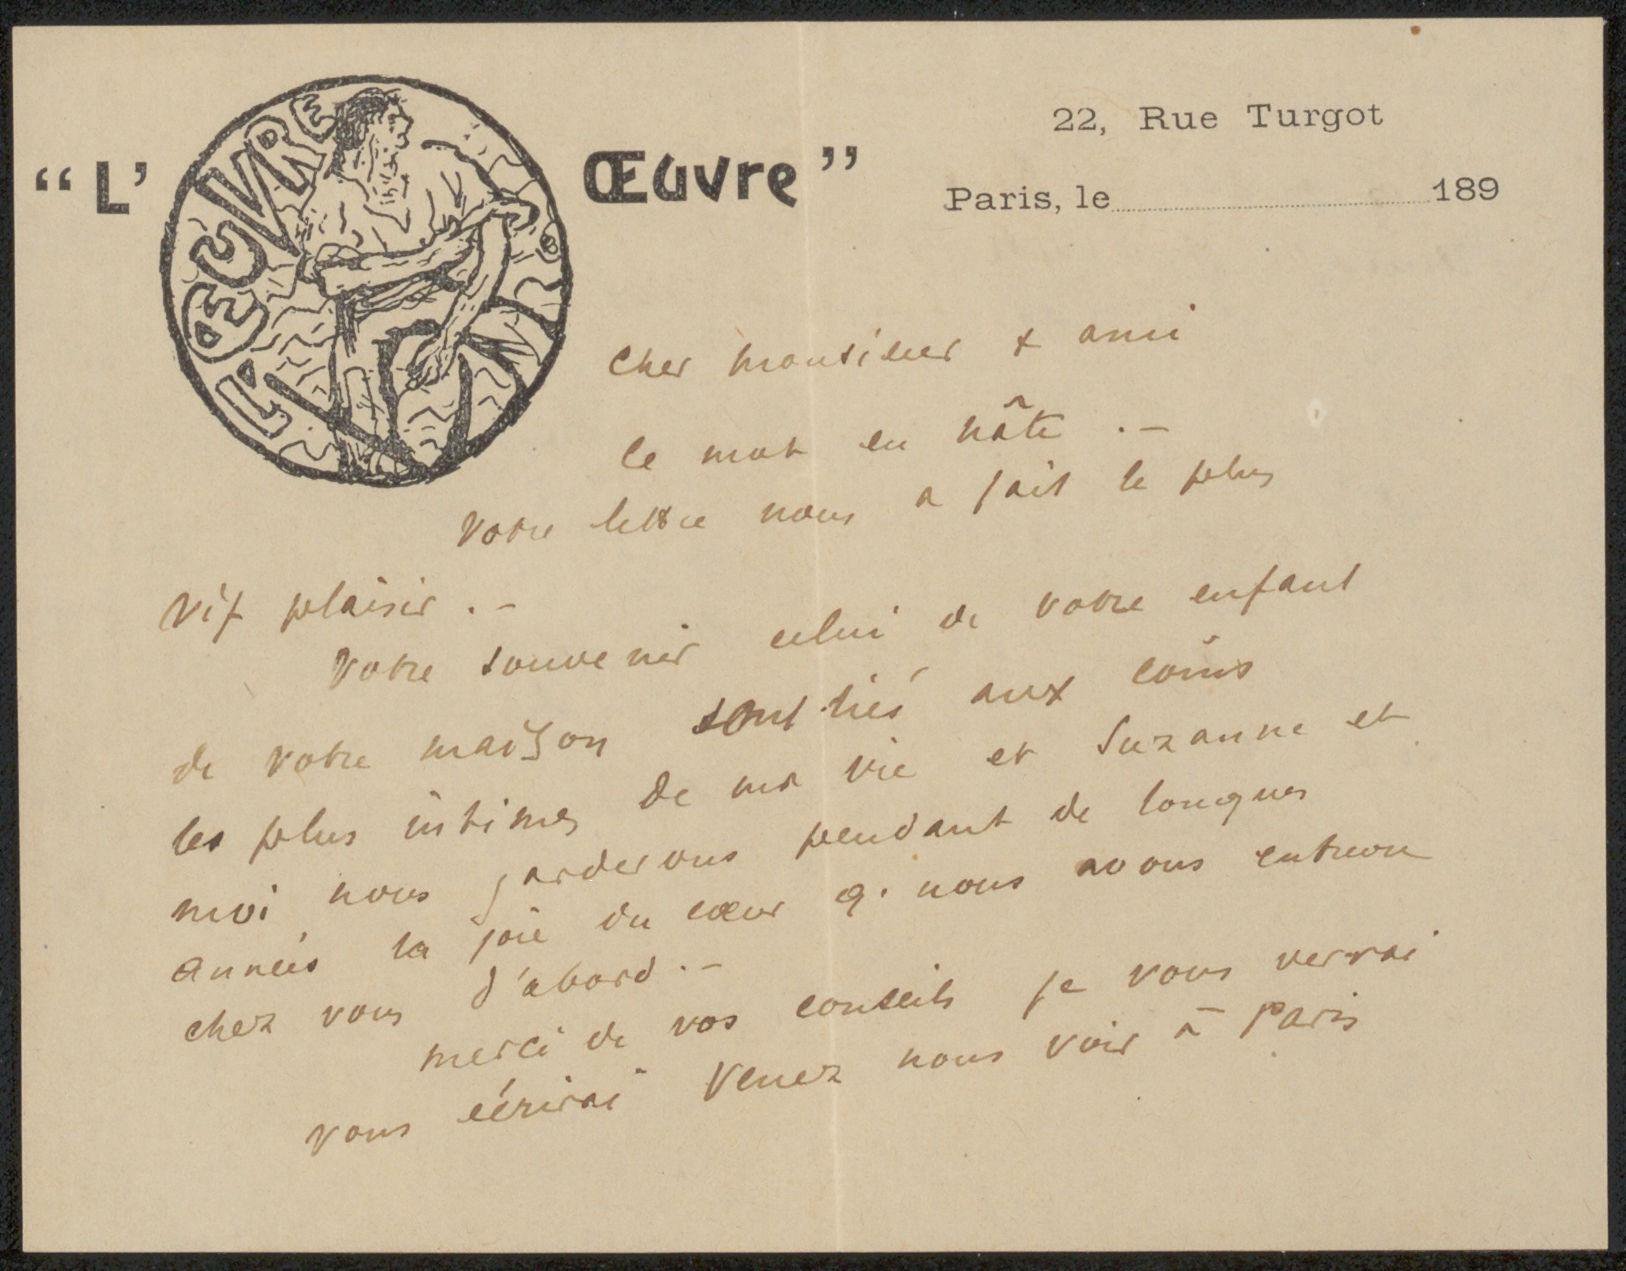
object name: letter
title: Brief aan Philip Zilcken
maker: lugné-poe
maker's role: acteur, theaterdirecteur, theatervormgever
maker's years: 1869-1940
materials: ink, paper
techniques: pen, printing, writing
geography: paris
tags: paris, suzanne desprès, painter, draughtsman, philip zilcken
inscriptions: collector's mark: ‘RPK’